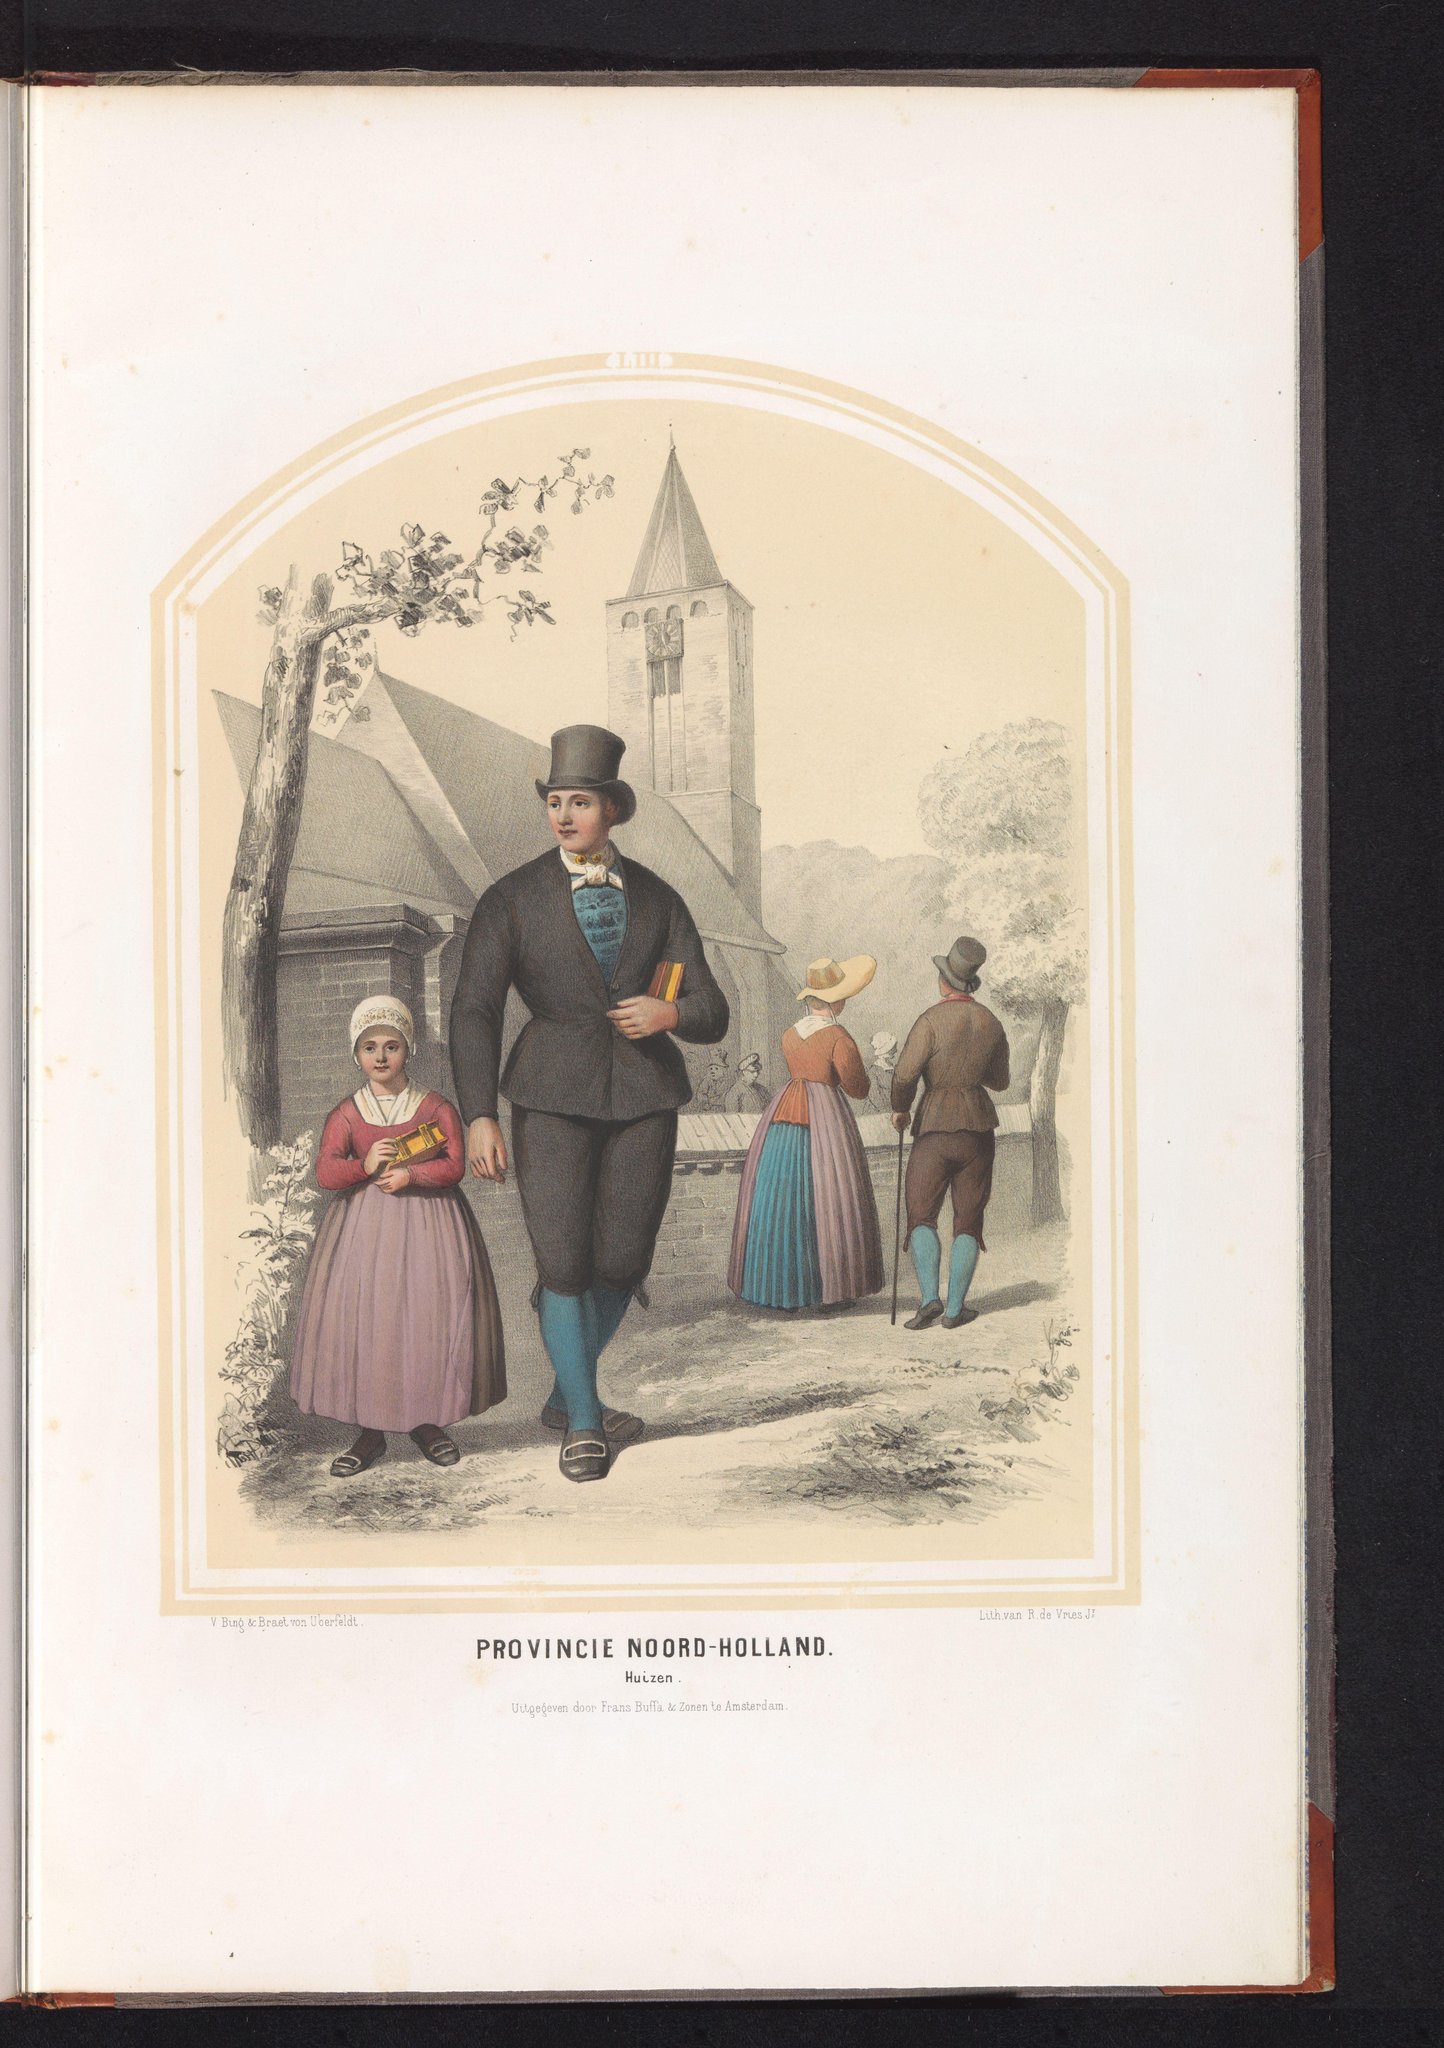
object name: print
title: Klederdracht van Huizen in Noord-Holland, 1857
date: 1857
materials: paper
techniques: hand coloring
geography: amsterdam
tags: folk costume, regional costume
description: Klederdracht van de plaats Huizen in de provincie Noord-Holland. Kerkgangers. Illustratie in een boek uit 1857 met 56 platen van Nederlandse klederdrachten.